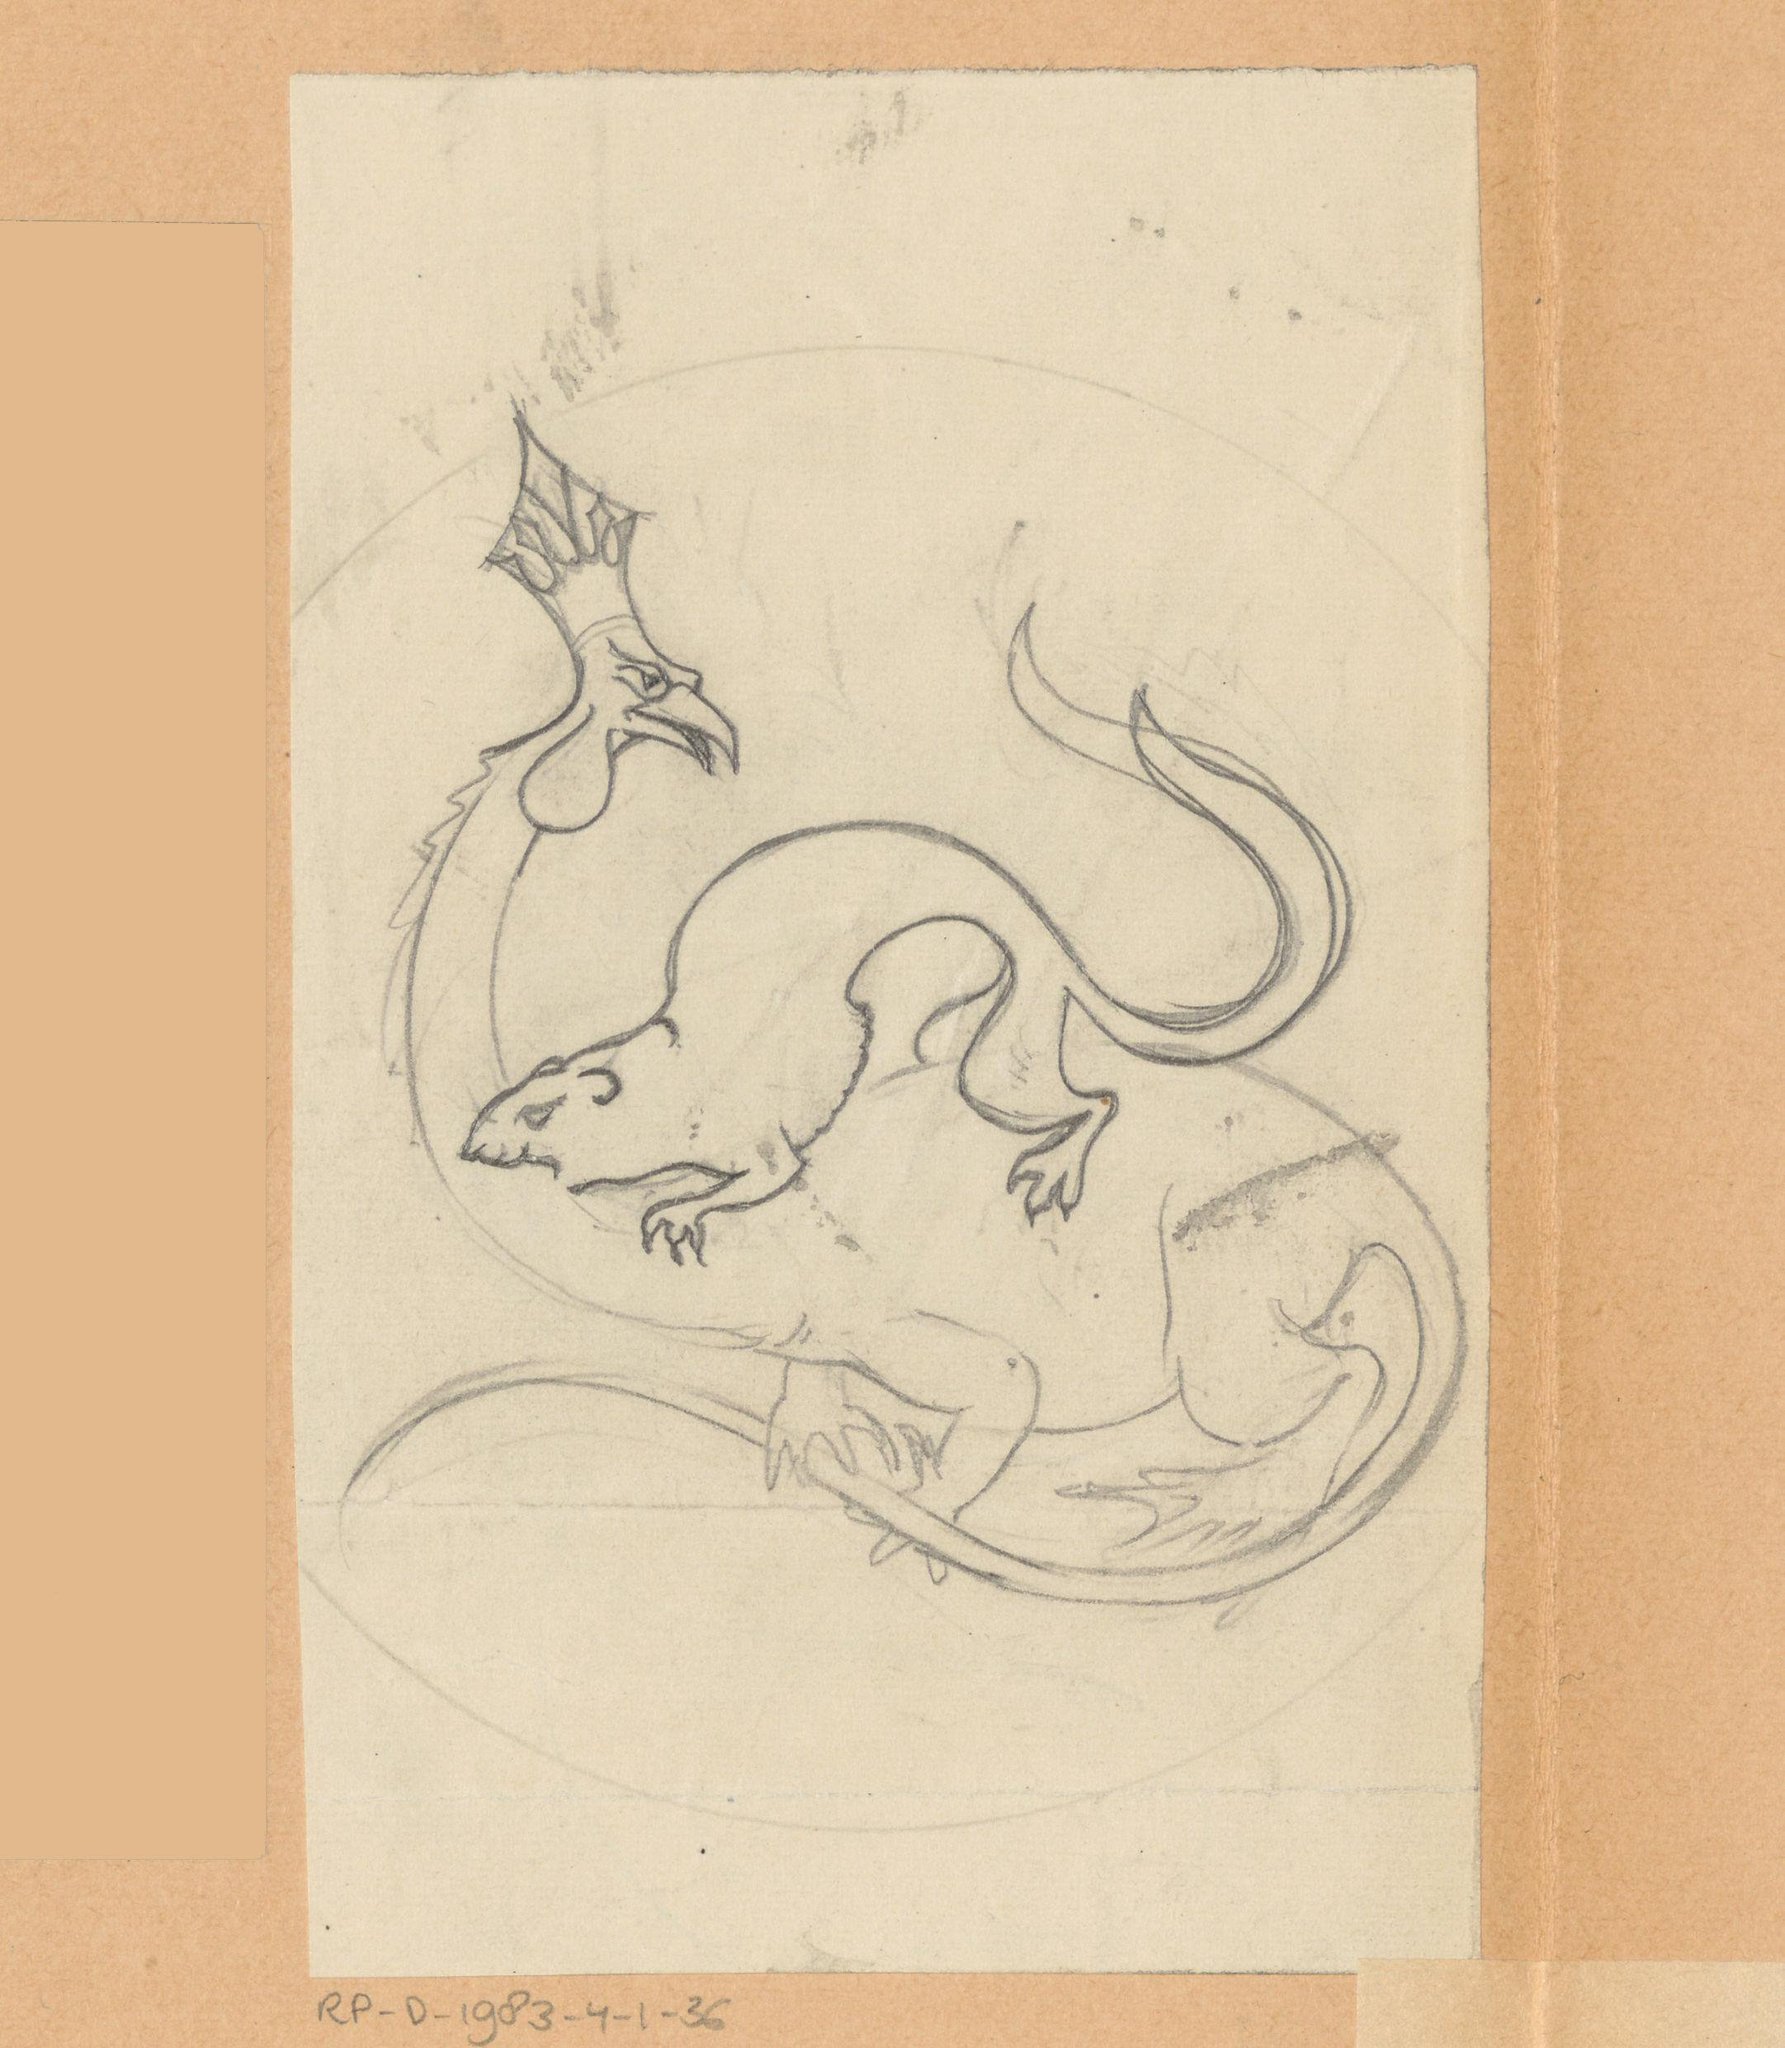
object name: bookplate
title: Ontwerp voor ex libris van F.A. Schaly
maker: otto verhagen (i)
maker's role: draughtsman, print maker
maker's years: 1885-1951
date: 1929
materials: paper, pencil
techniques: drawing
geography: netherlands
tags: crown (symbol of sovereignty), griffin (lion/eagle); 'griffo' (ripa), rodents: rat